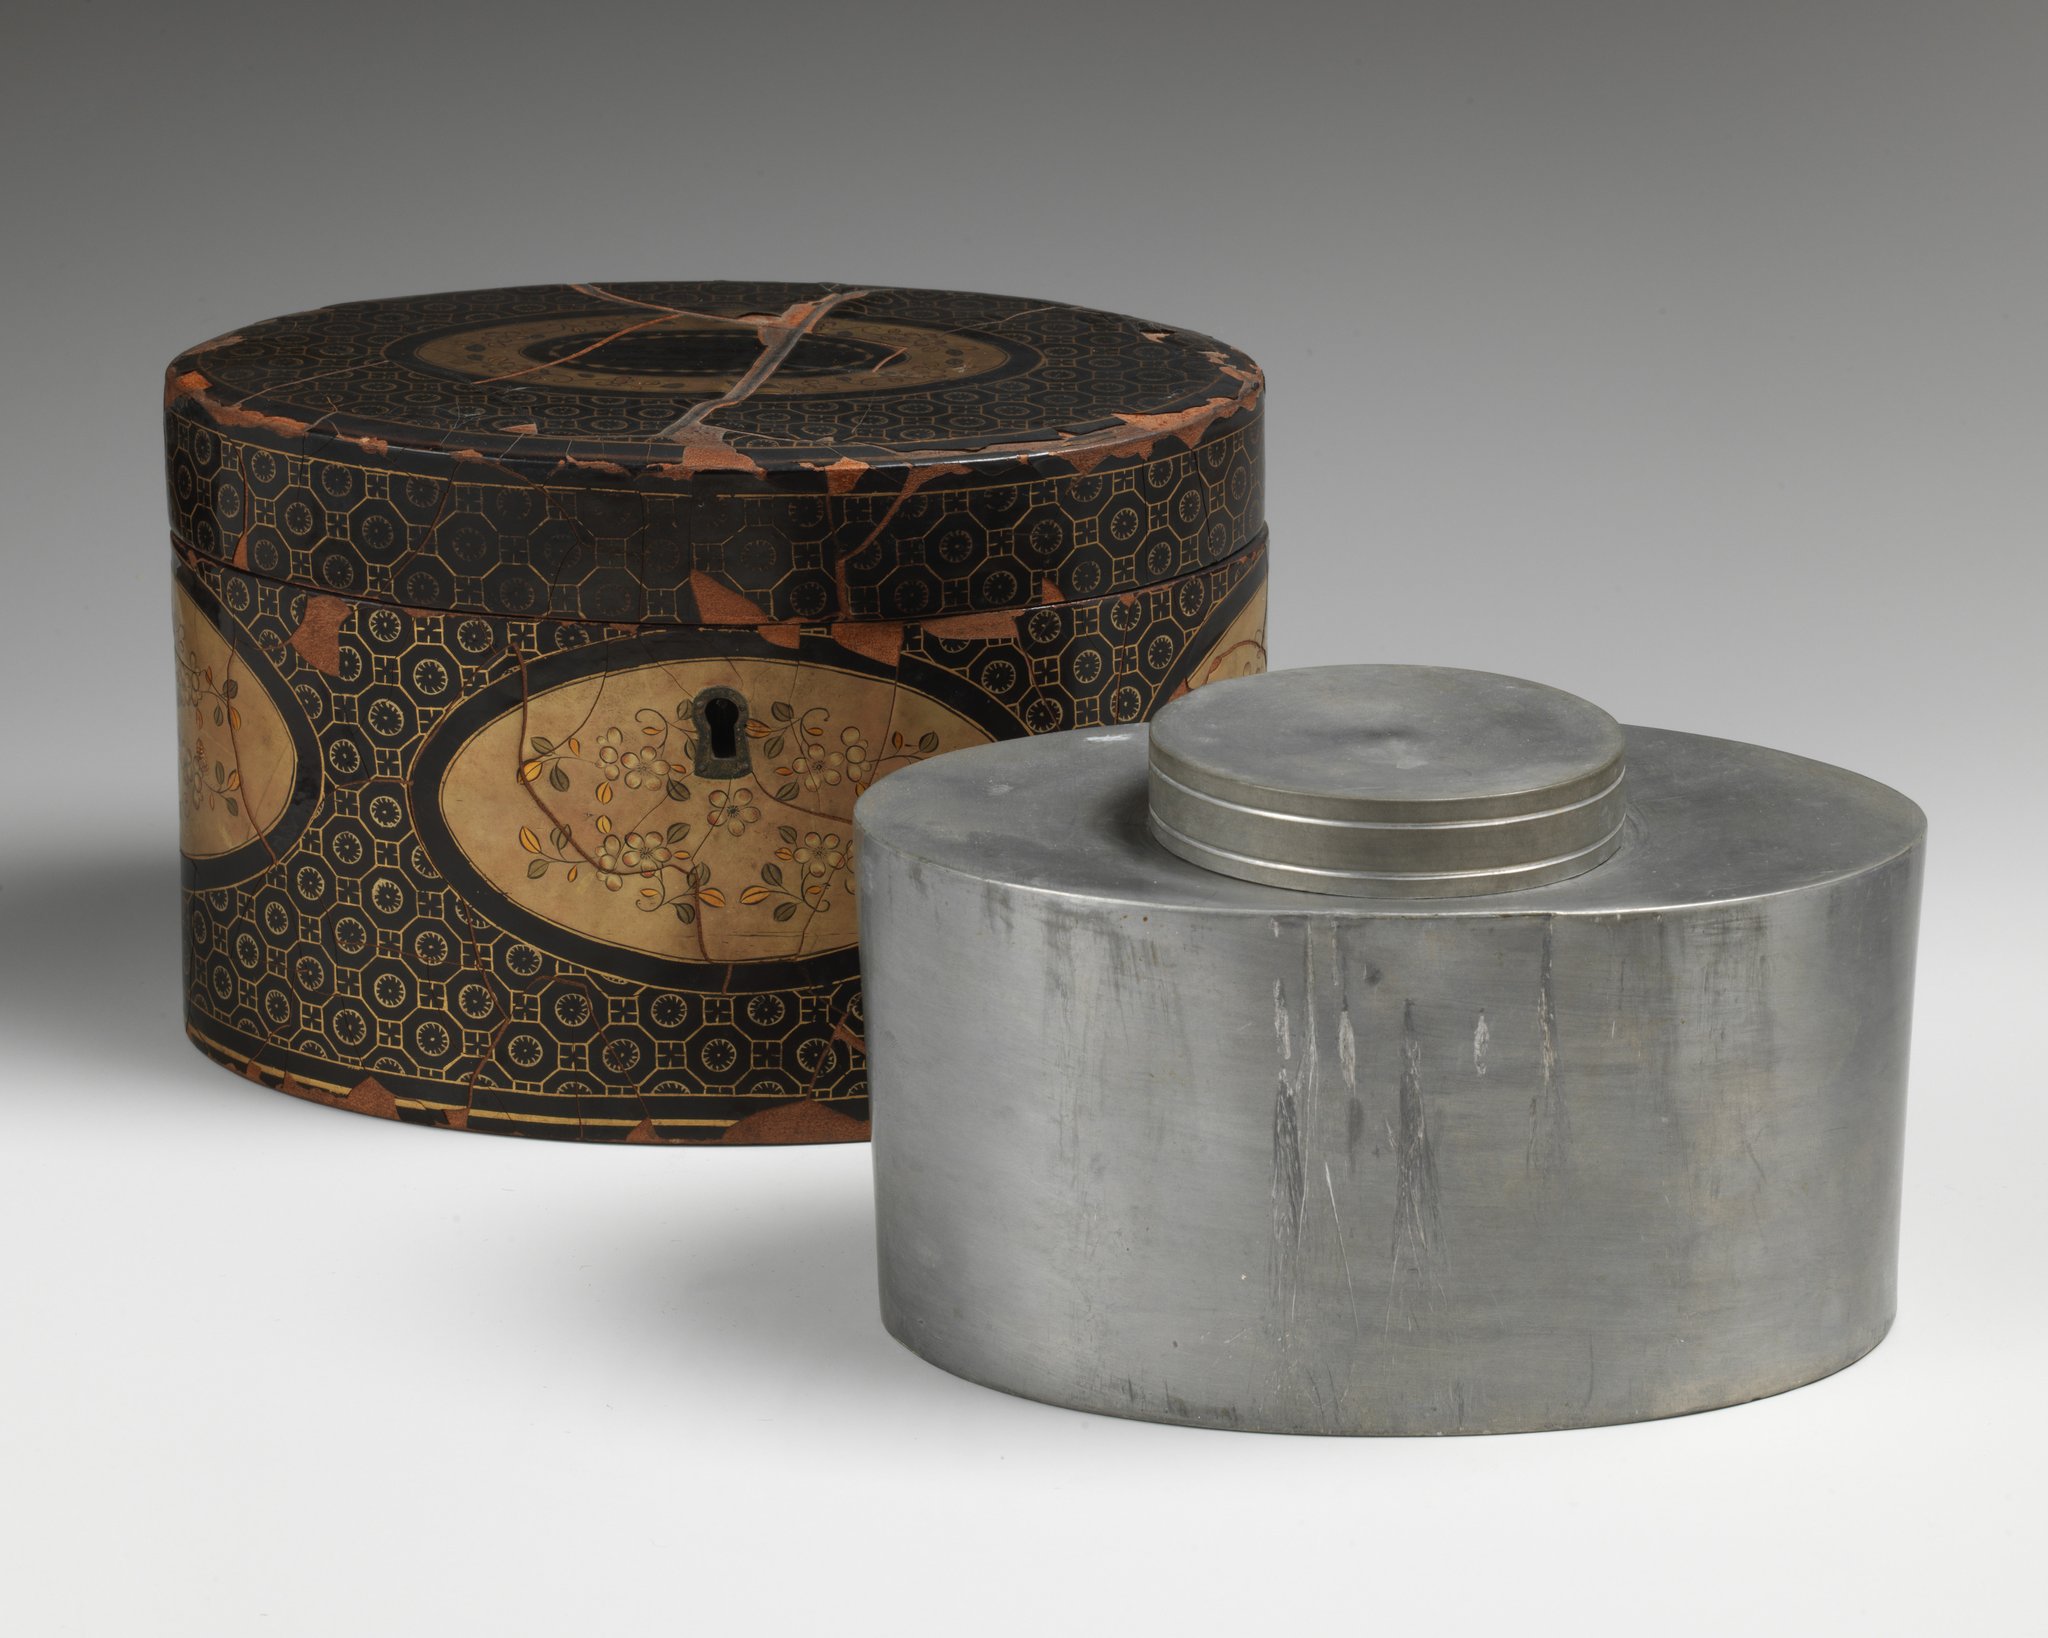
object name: tea caddy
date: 1701-1900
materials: lacquer, pewter